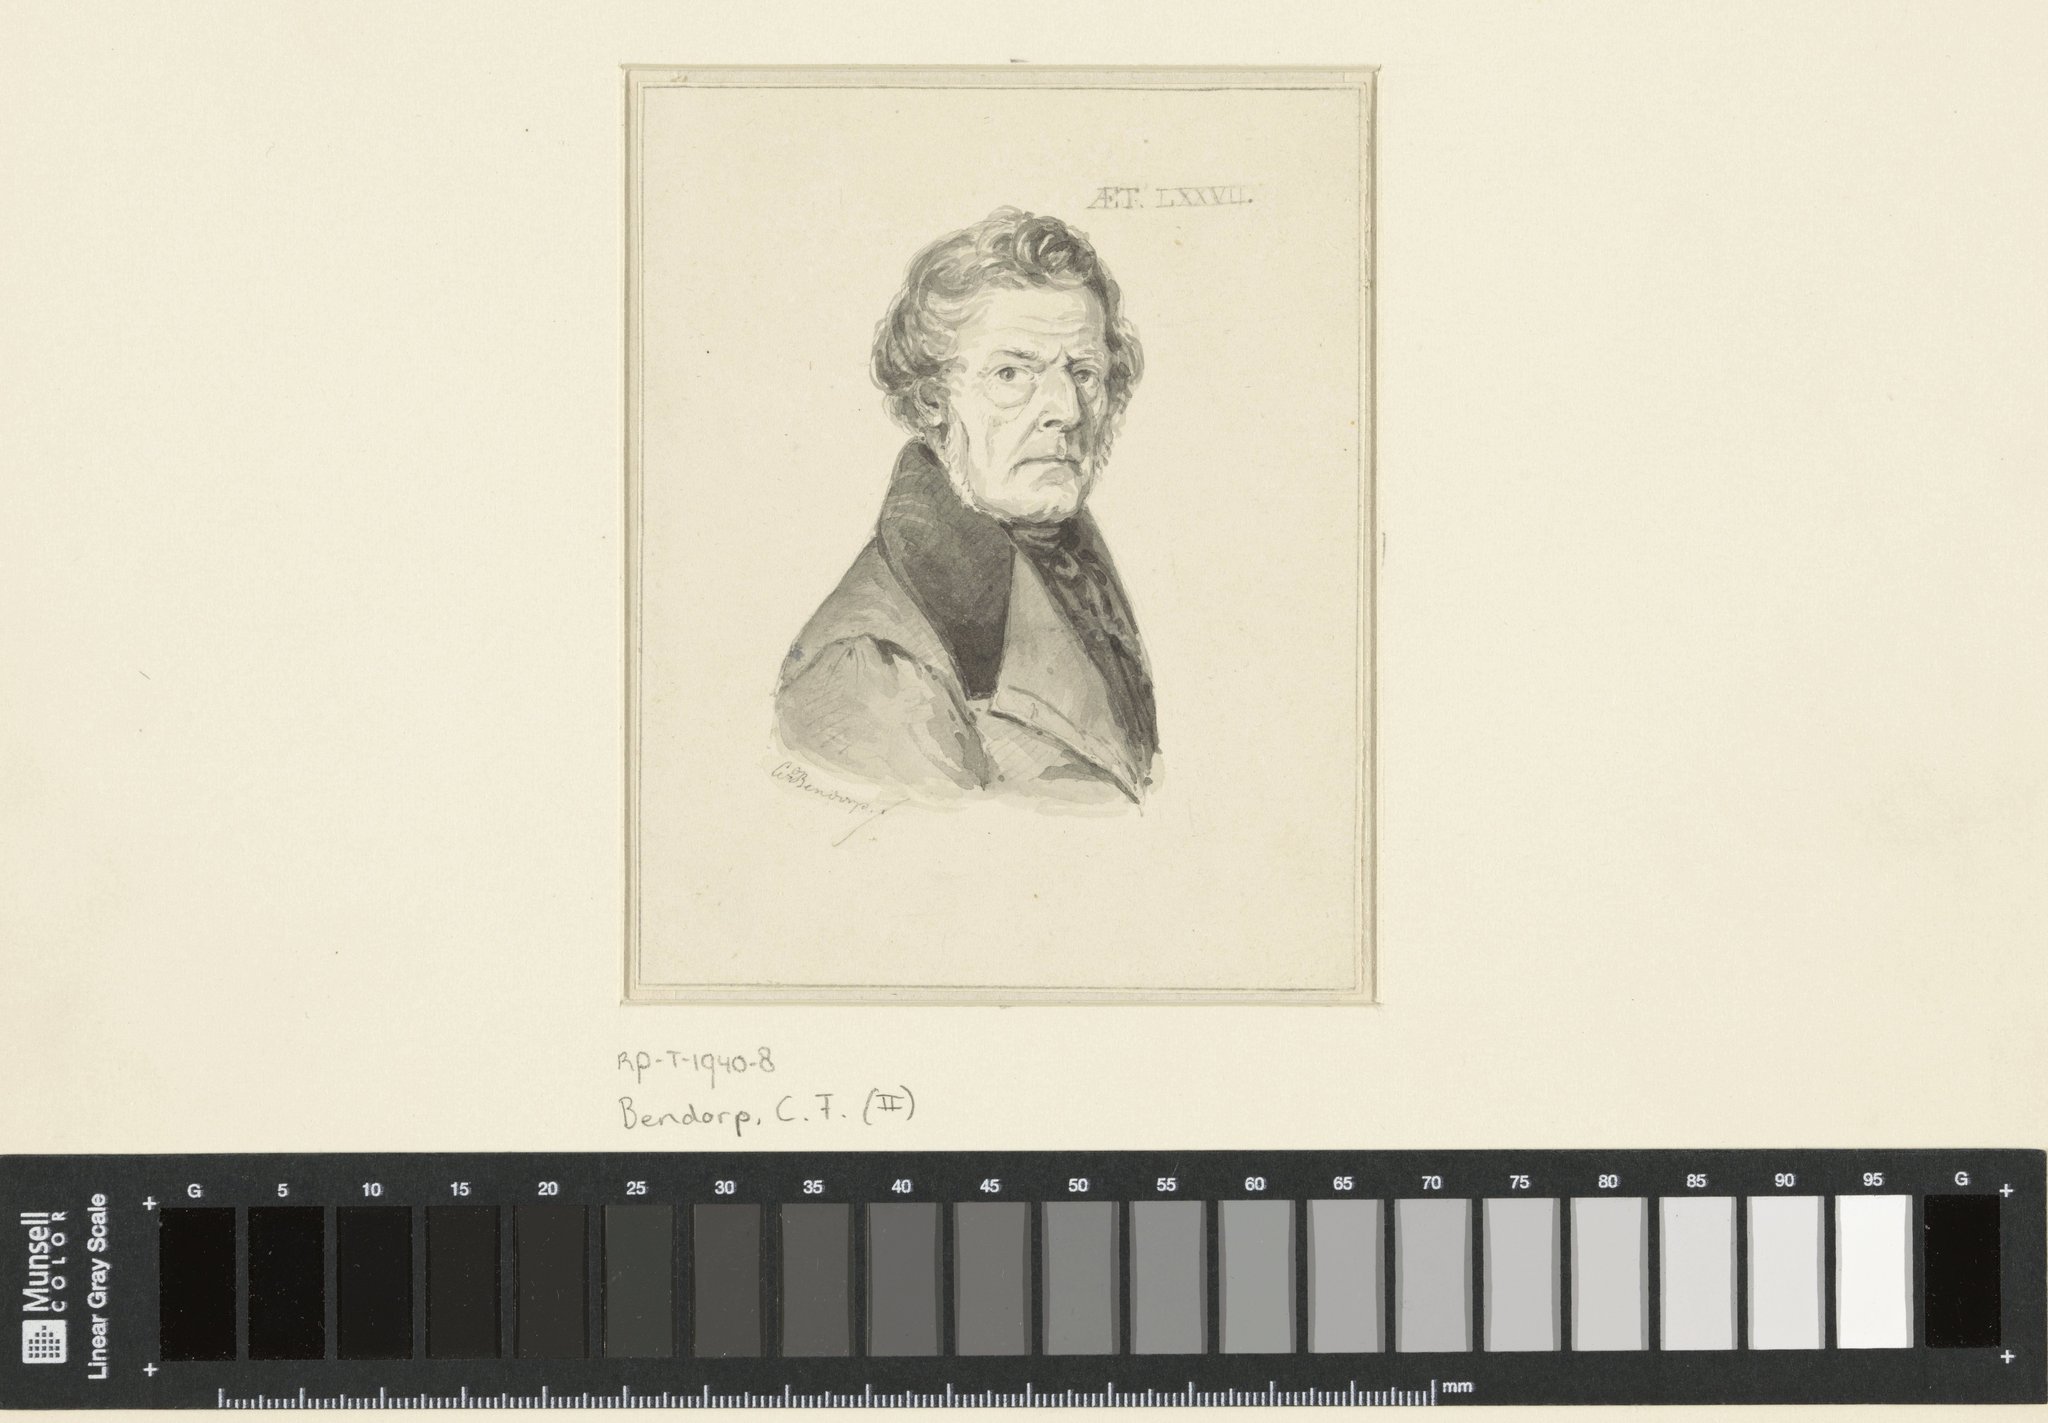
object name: drawing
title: Portret van Johannes Christiaan Bendorp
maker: carel frederik bendorp (ii)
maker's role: draughtsman, painter, print maker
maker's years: 1819-1897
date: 1843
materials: ink, paper, pencil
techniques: brush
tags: johannes christiaan bendorp, historical persons, portrait, self-portrait of painter, portrait, self-portrait of artist, portrait, self-portrait of draughtsman